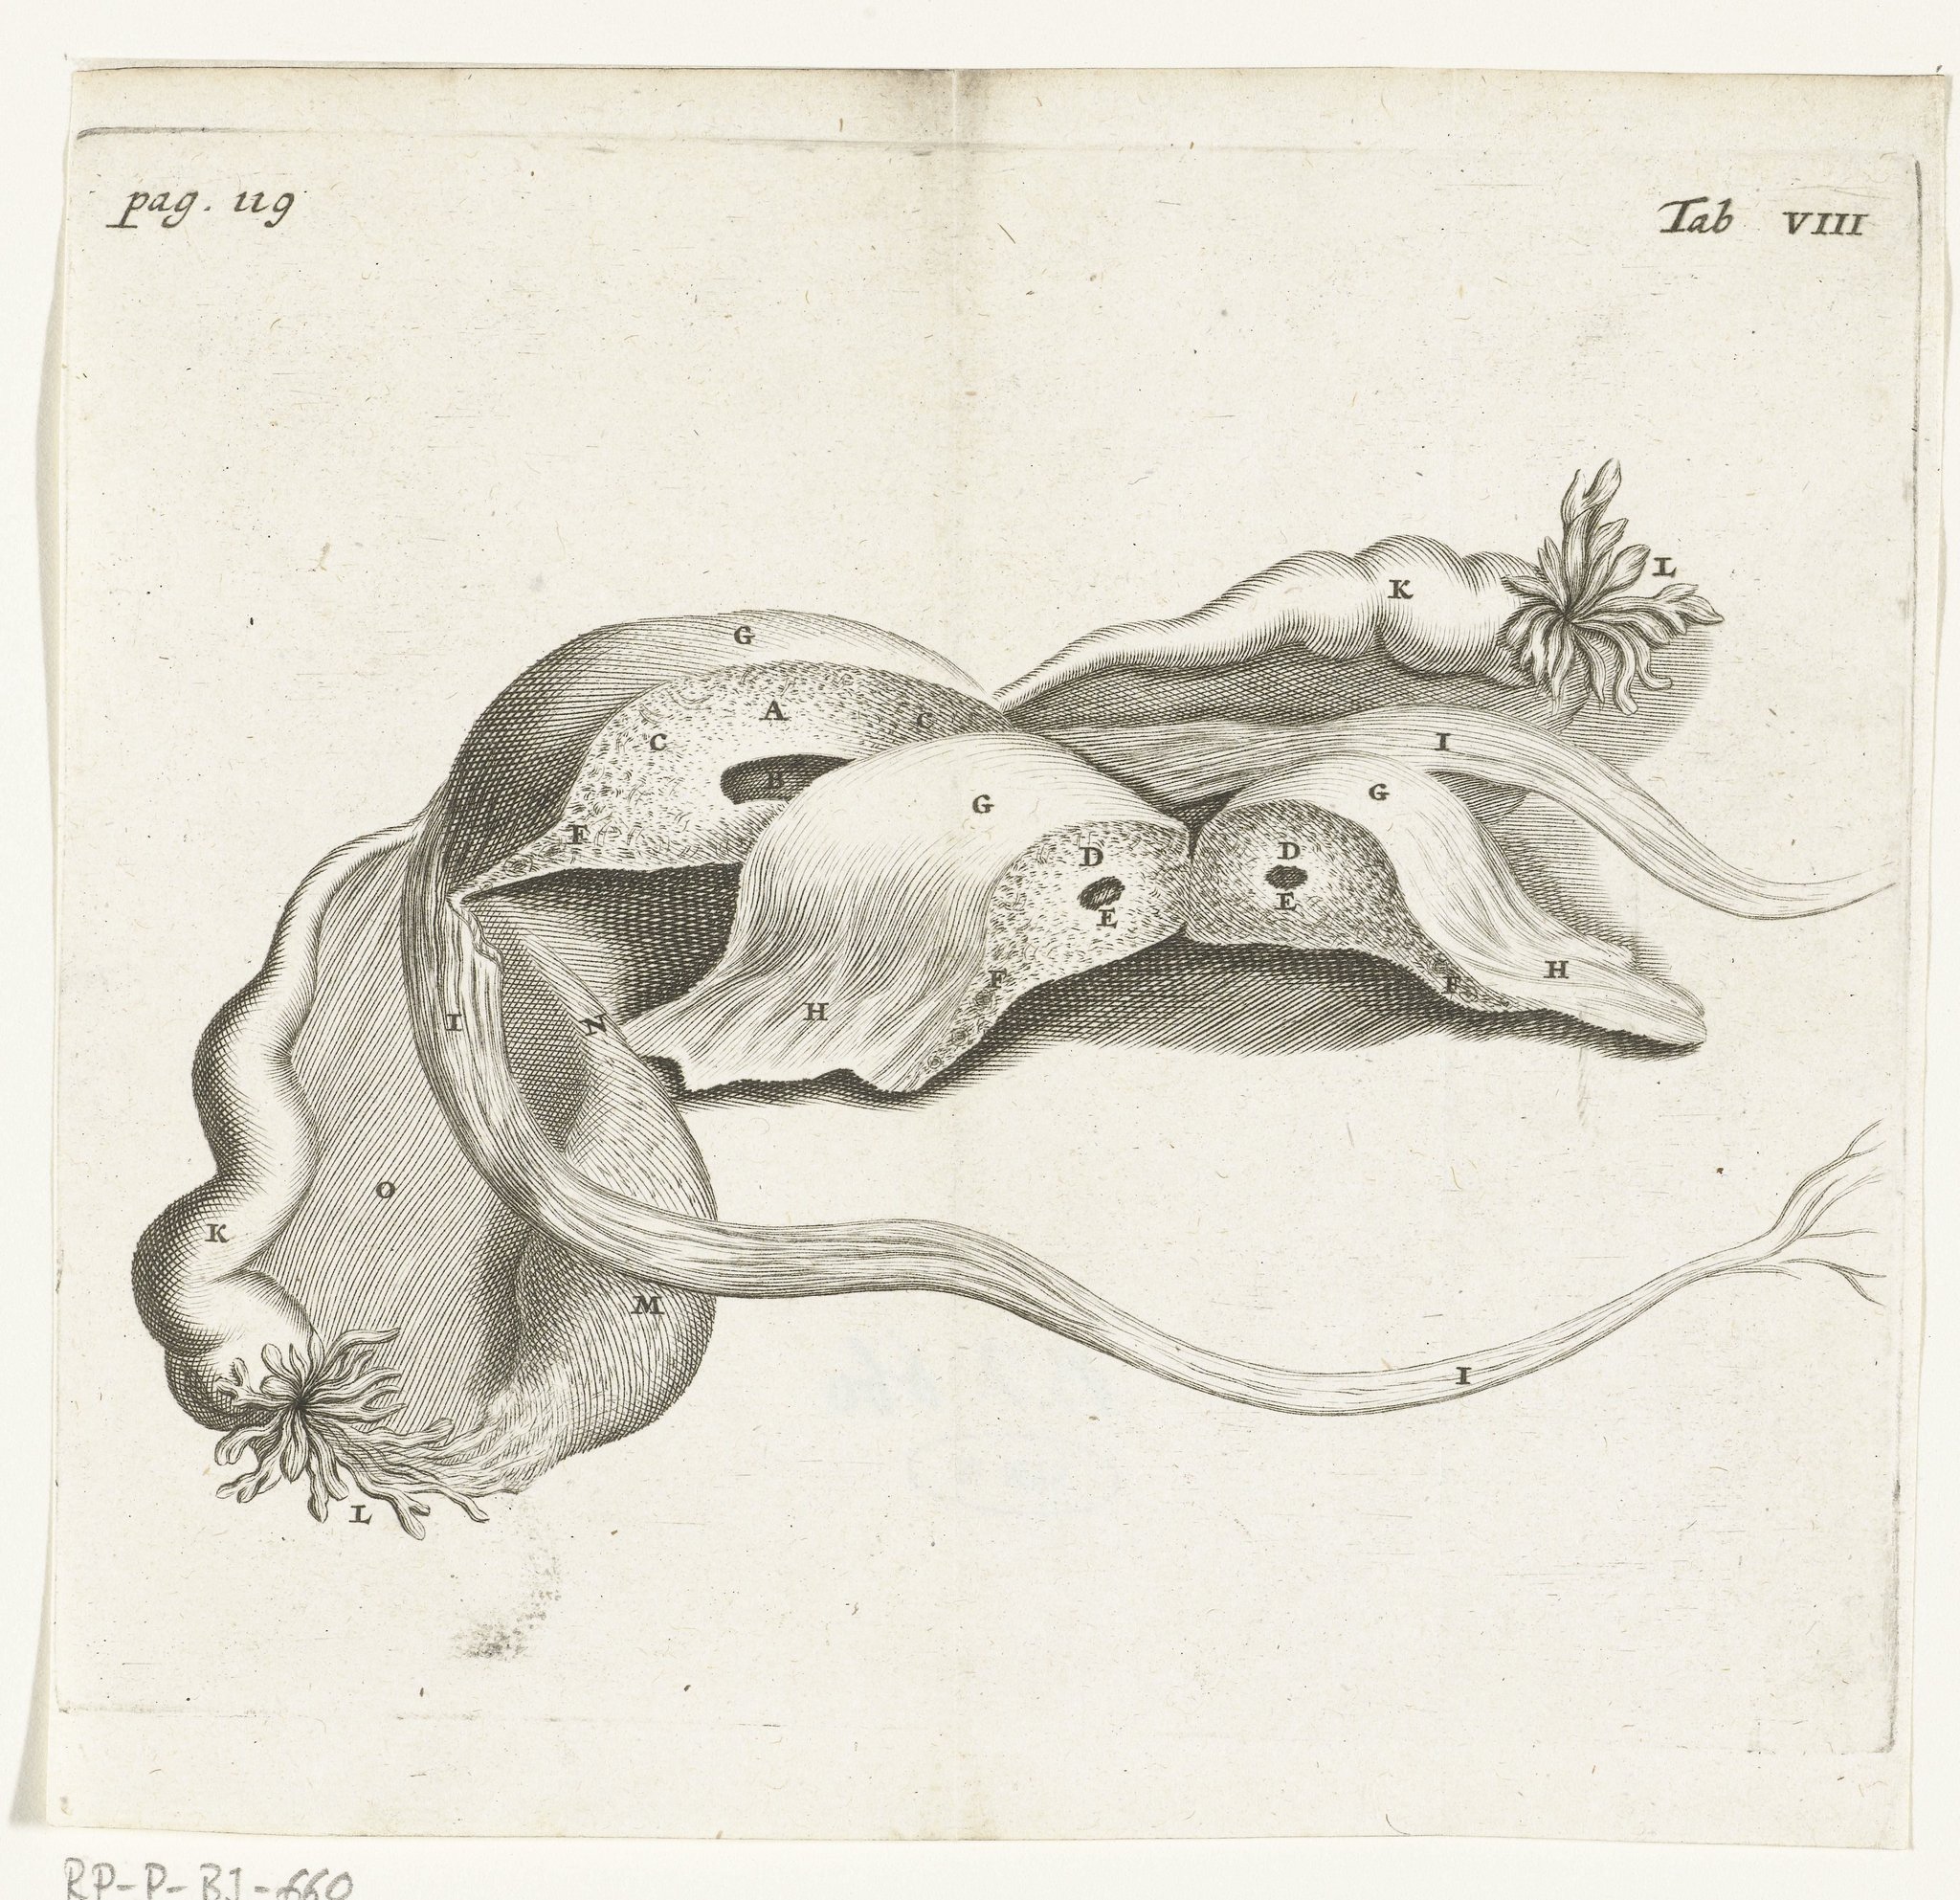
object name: book illustration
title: Anatomical depiction of an ectopic pregnancy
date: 1672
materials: paper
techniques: drypoint, engraving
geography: netherlands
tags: womb, uterus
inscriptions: collector's mark: Lugt 2228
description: In 1672 physician and anatomist Reinier de Graaf published De mulierum organis, a book about the organs of the female body, with prints by Hendrik Bary. De Graaf was the first to conclude that a foetus grows from the mother’s egg cell after it is fertilised by the father’s seed. He also discusses anomalies such as ectopic pregnancies (when the fertilised egg implants outside the womb).